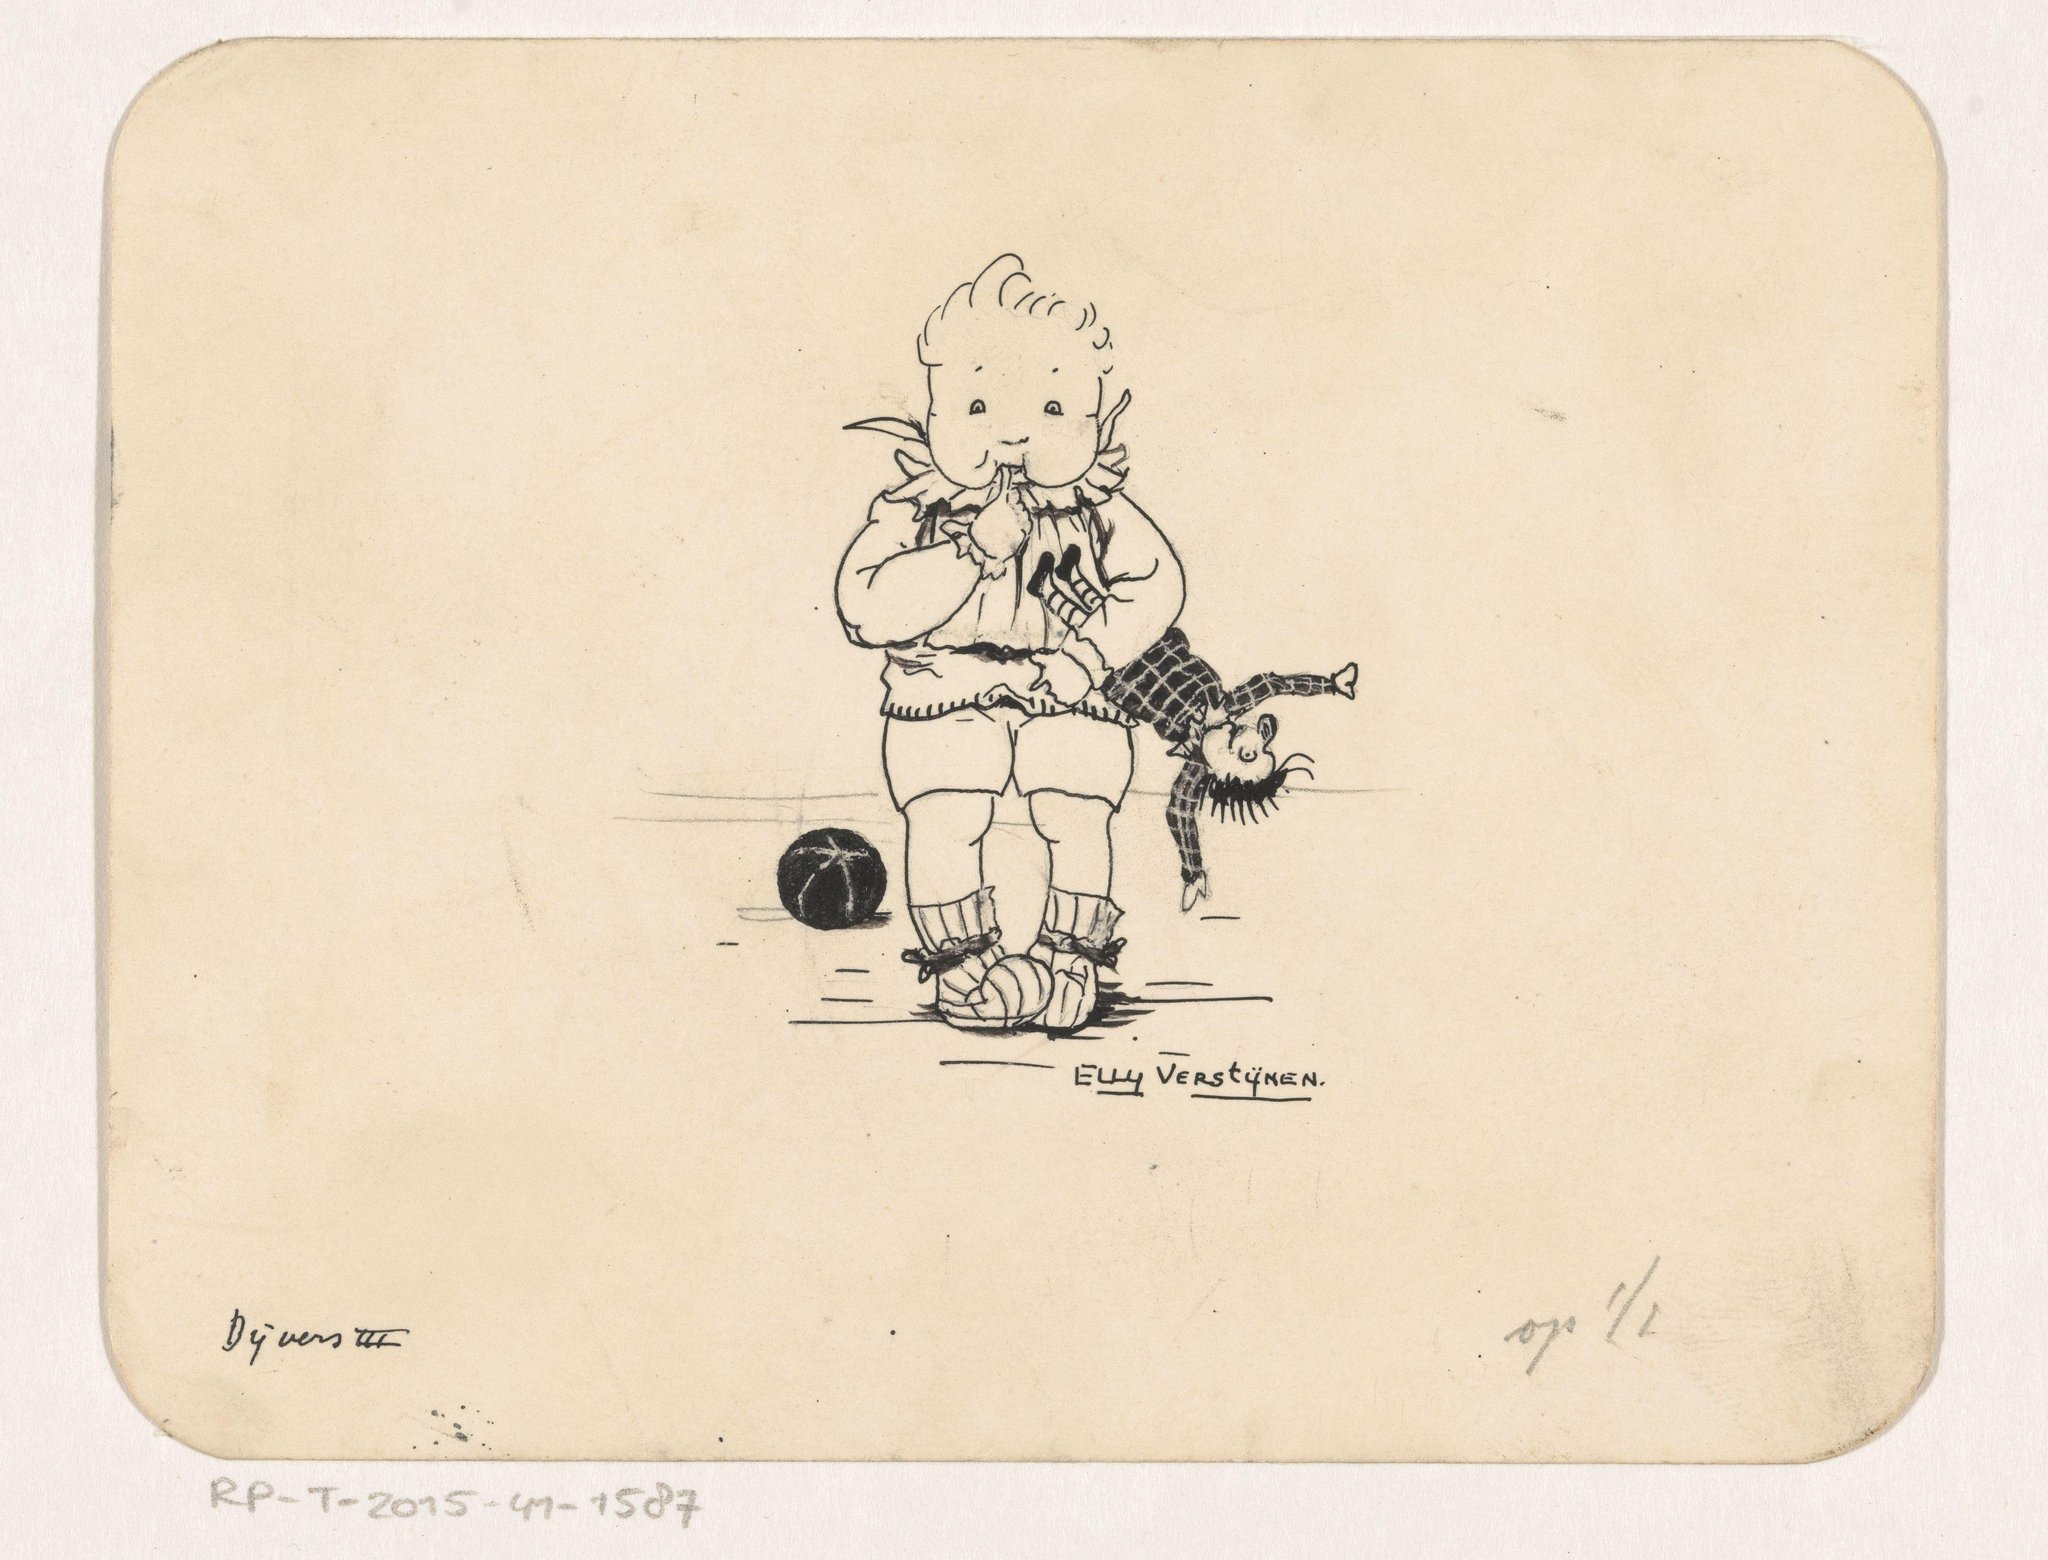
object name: drawing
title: Jongen met pop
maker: elly verstijnen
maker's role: draughtsman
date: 1900-1930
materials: ink, paper, pencil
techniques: brush, pen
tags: thumb-sucking, (playing with) dolls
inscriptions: :, collector's mark: Lugt 2228, annotation: ‘Dijvers III’, signature: ‘ELLY VERSTIJNEN.’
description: Een jongen staat met een pop onder zijn arm. Hij steekt zijn duim in zijn mond. Achter hem ligt een bal op de grond.